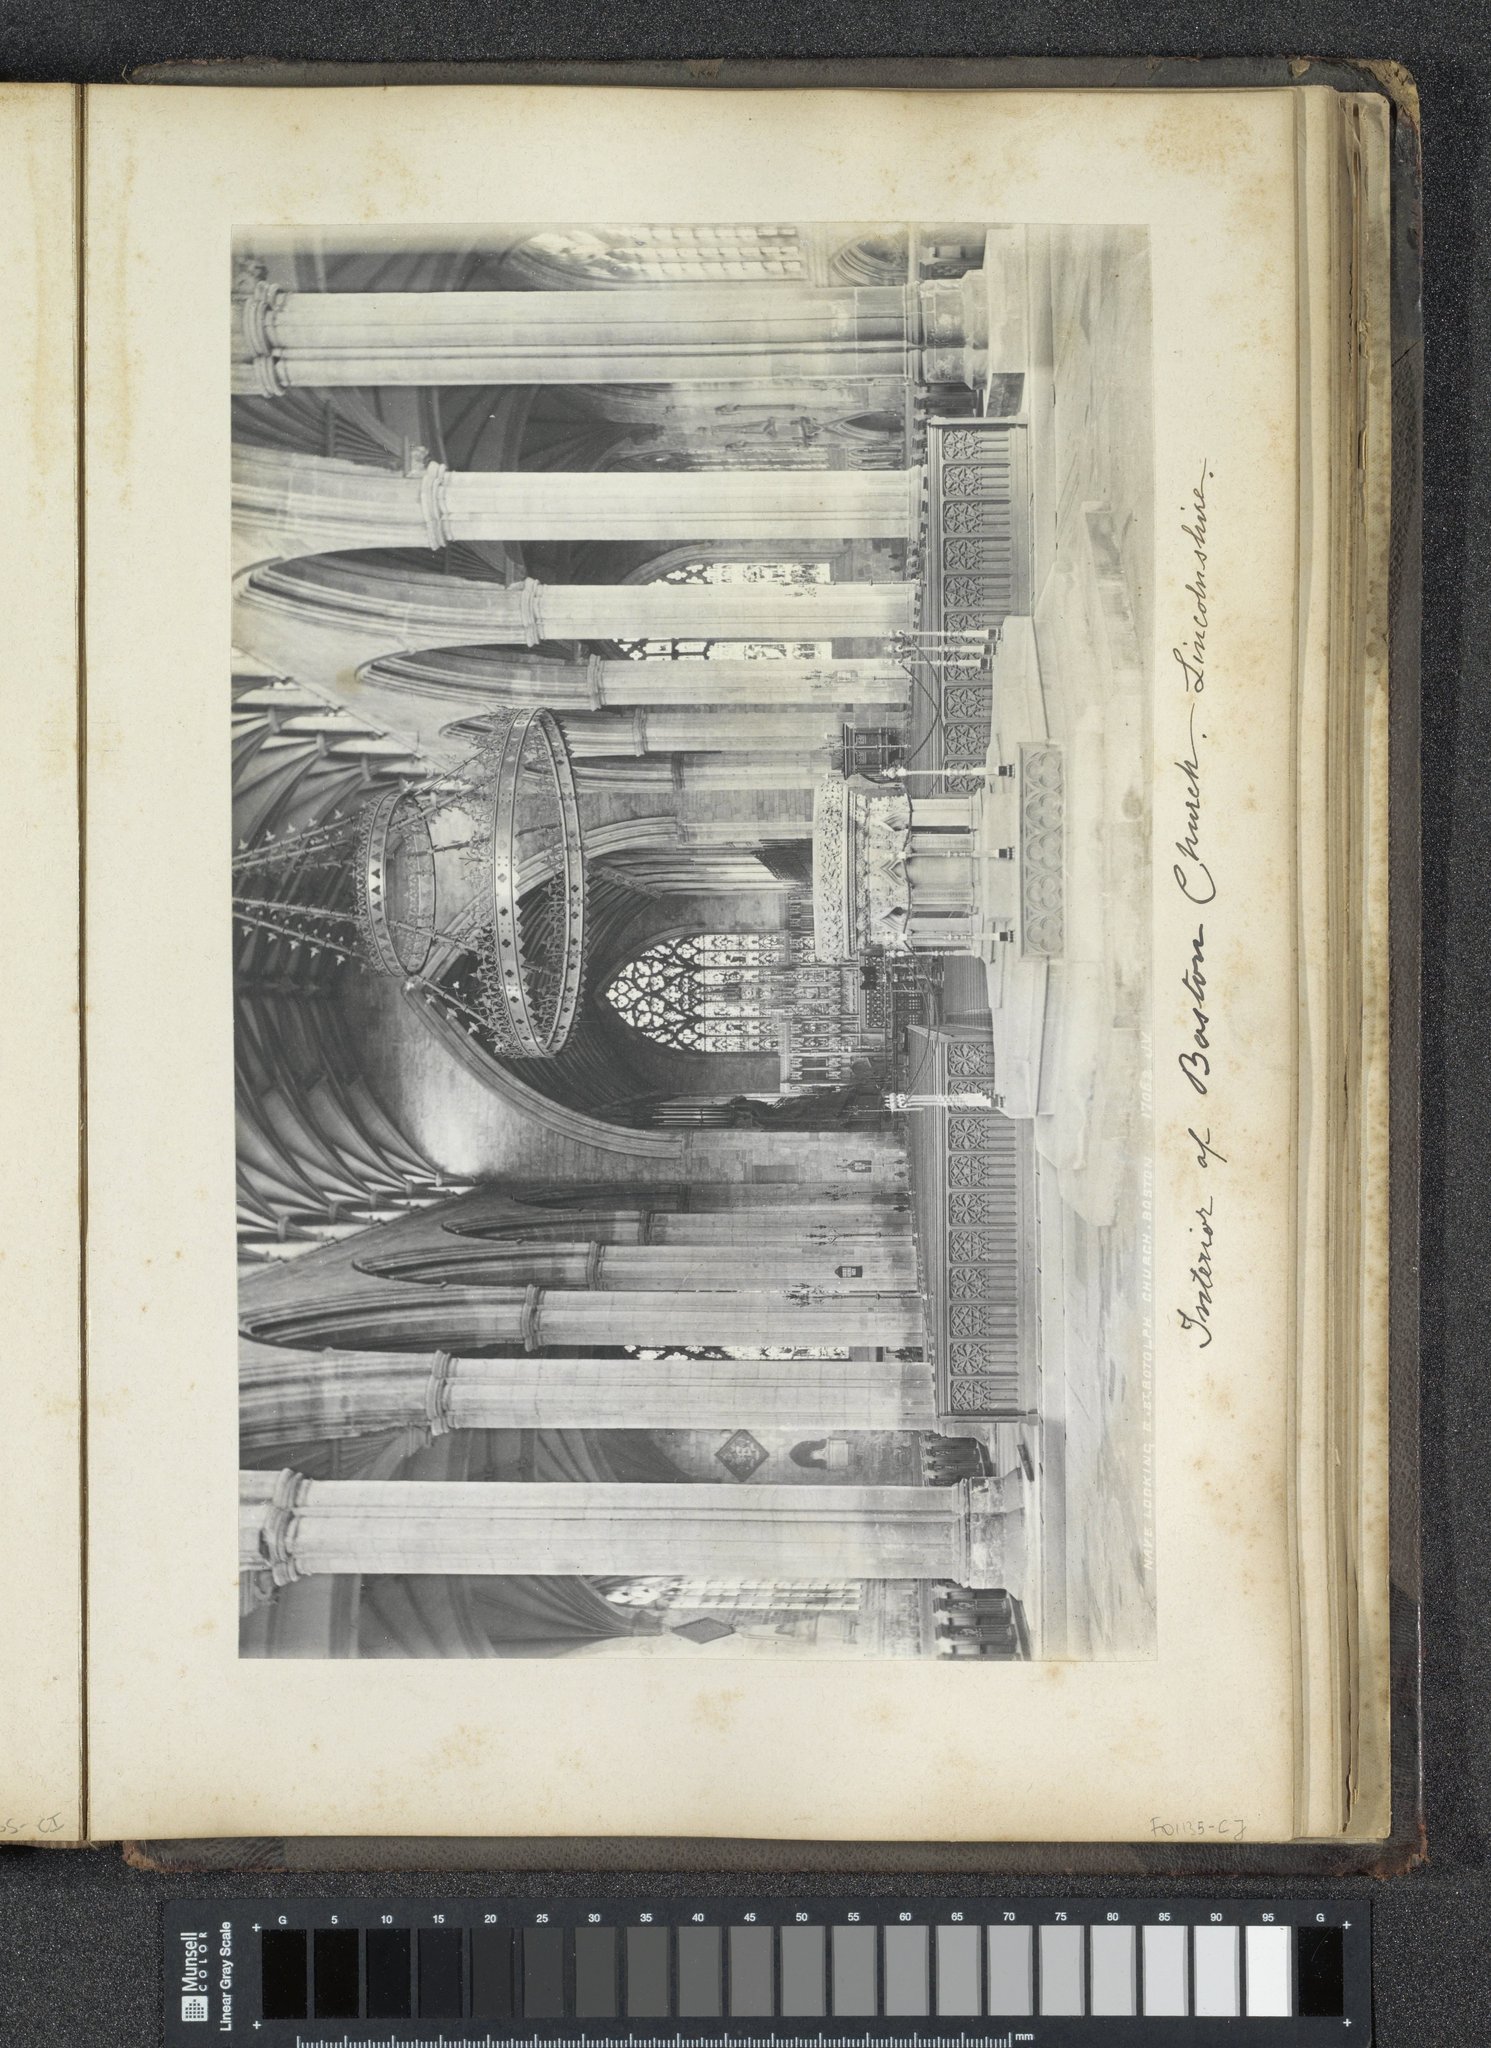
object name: album leaf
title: Interieur van St Botolph's Church in Boston (Engeland)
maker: james valentine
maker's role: fotograaf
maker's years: 1815-1880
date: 1900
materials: paper, photographic support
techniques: platinum process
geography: boston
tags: parts of church interior: nave, baptismal font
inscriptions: number: ‘17062’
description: Onderdeel van Reisalbum met foto's van bezienswaardigheden in Engeland en Frankrijk.